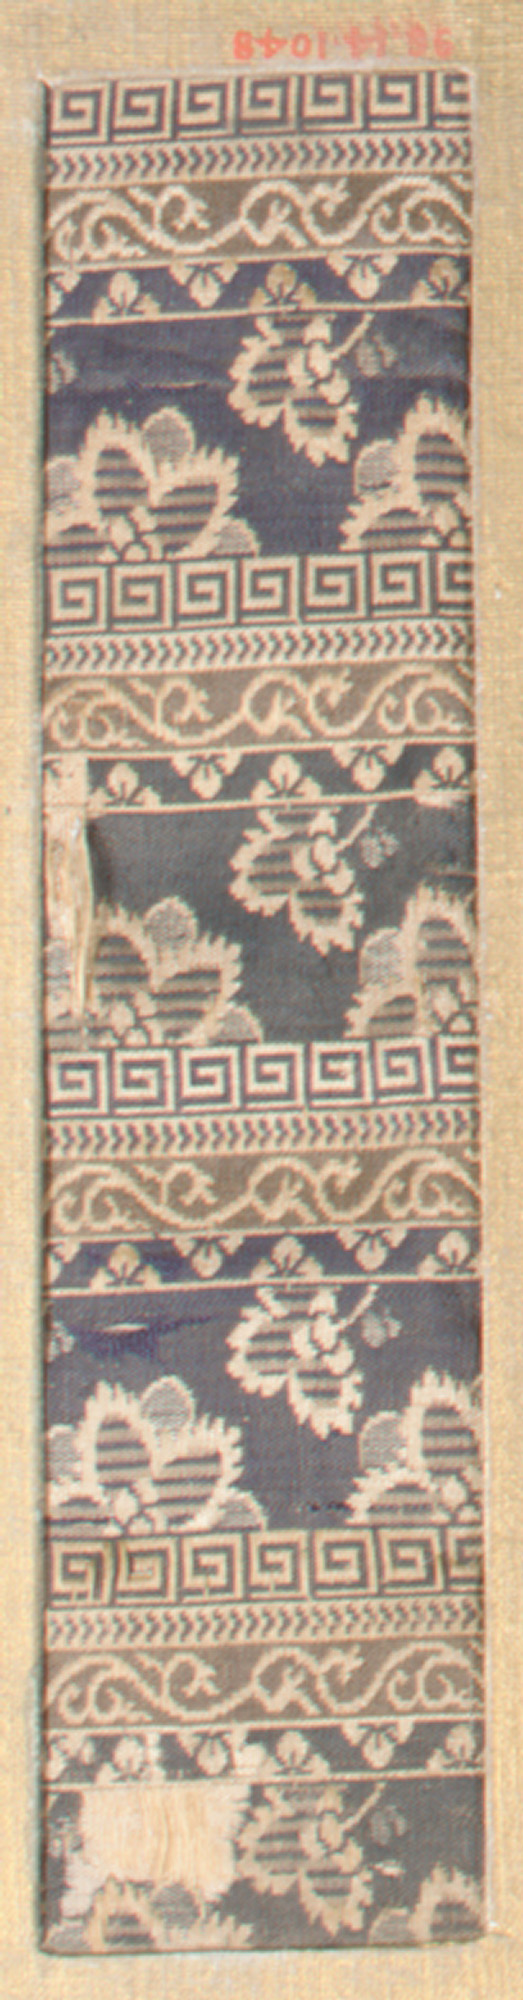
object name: piece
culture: japanese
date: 1701-1900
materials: silk